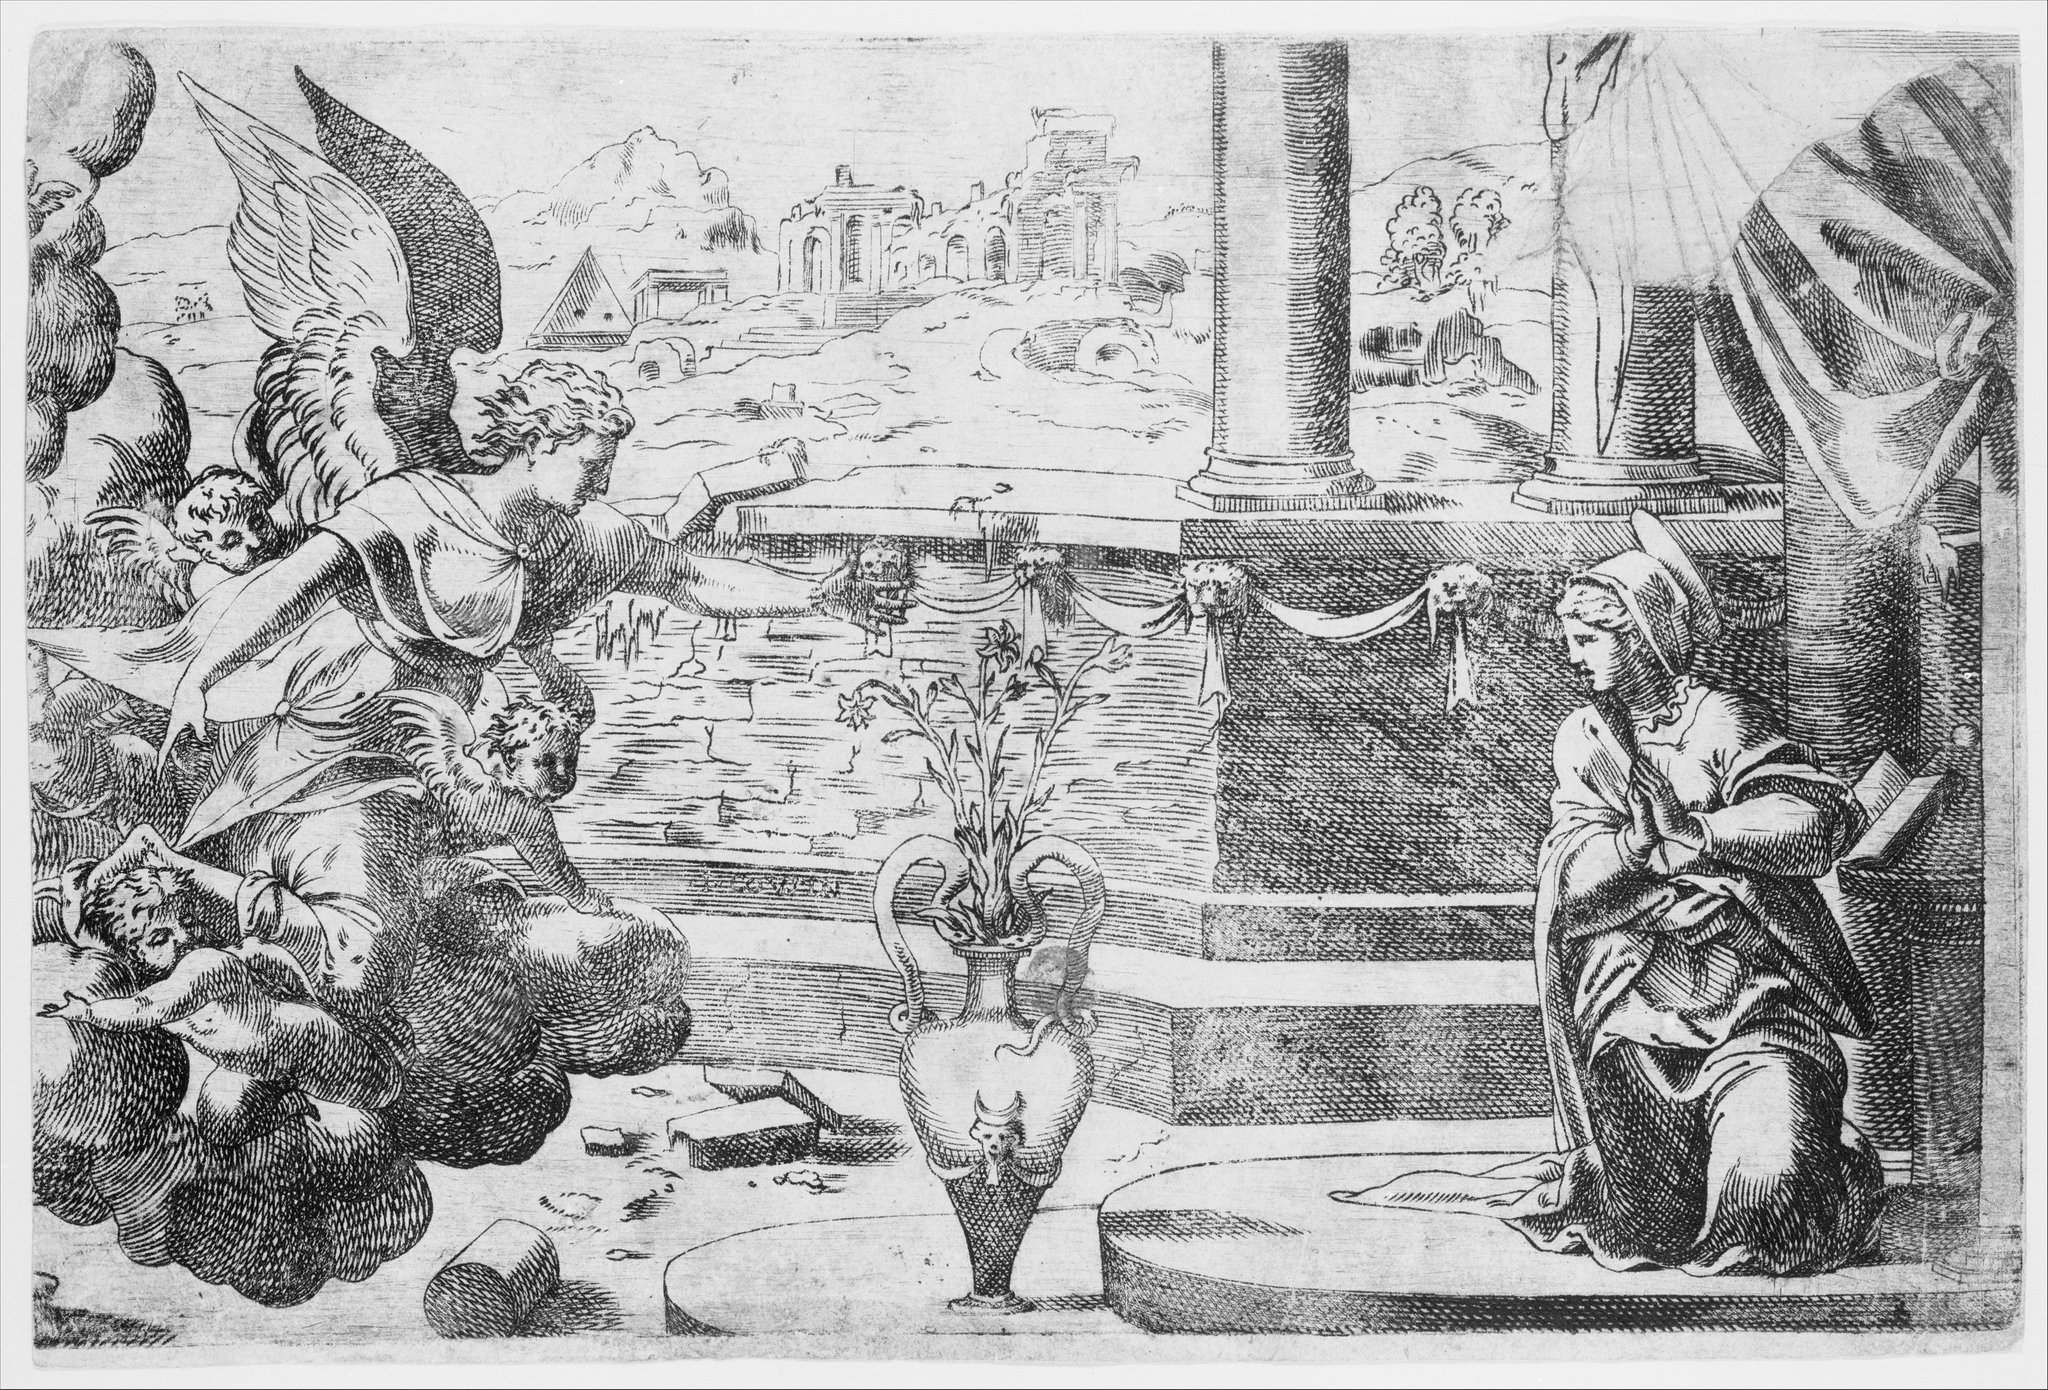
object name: print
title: The Annunciation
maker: jean cousin the elder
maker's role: artist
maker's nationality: french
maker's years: 1485-1565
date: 1544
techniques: engraving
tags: angels,virgin mary,archangel gabriel,annunciation